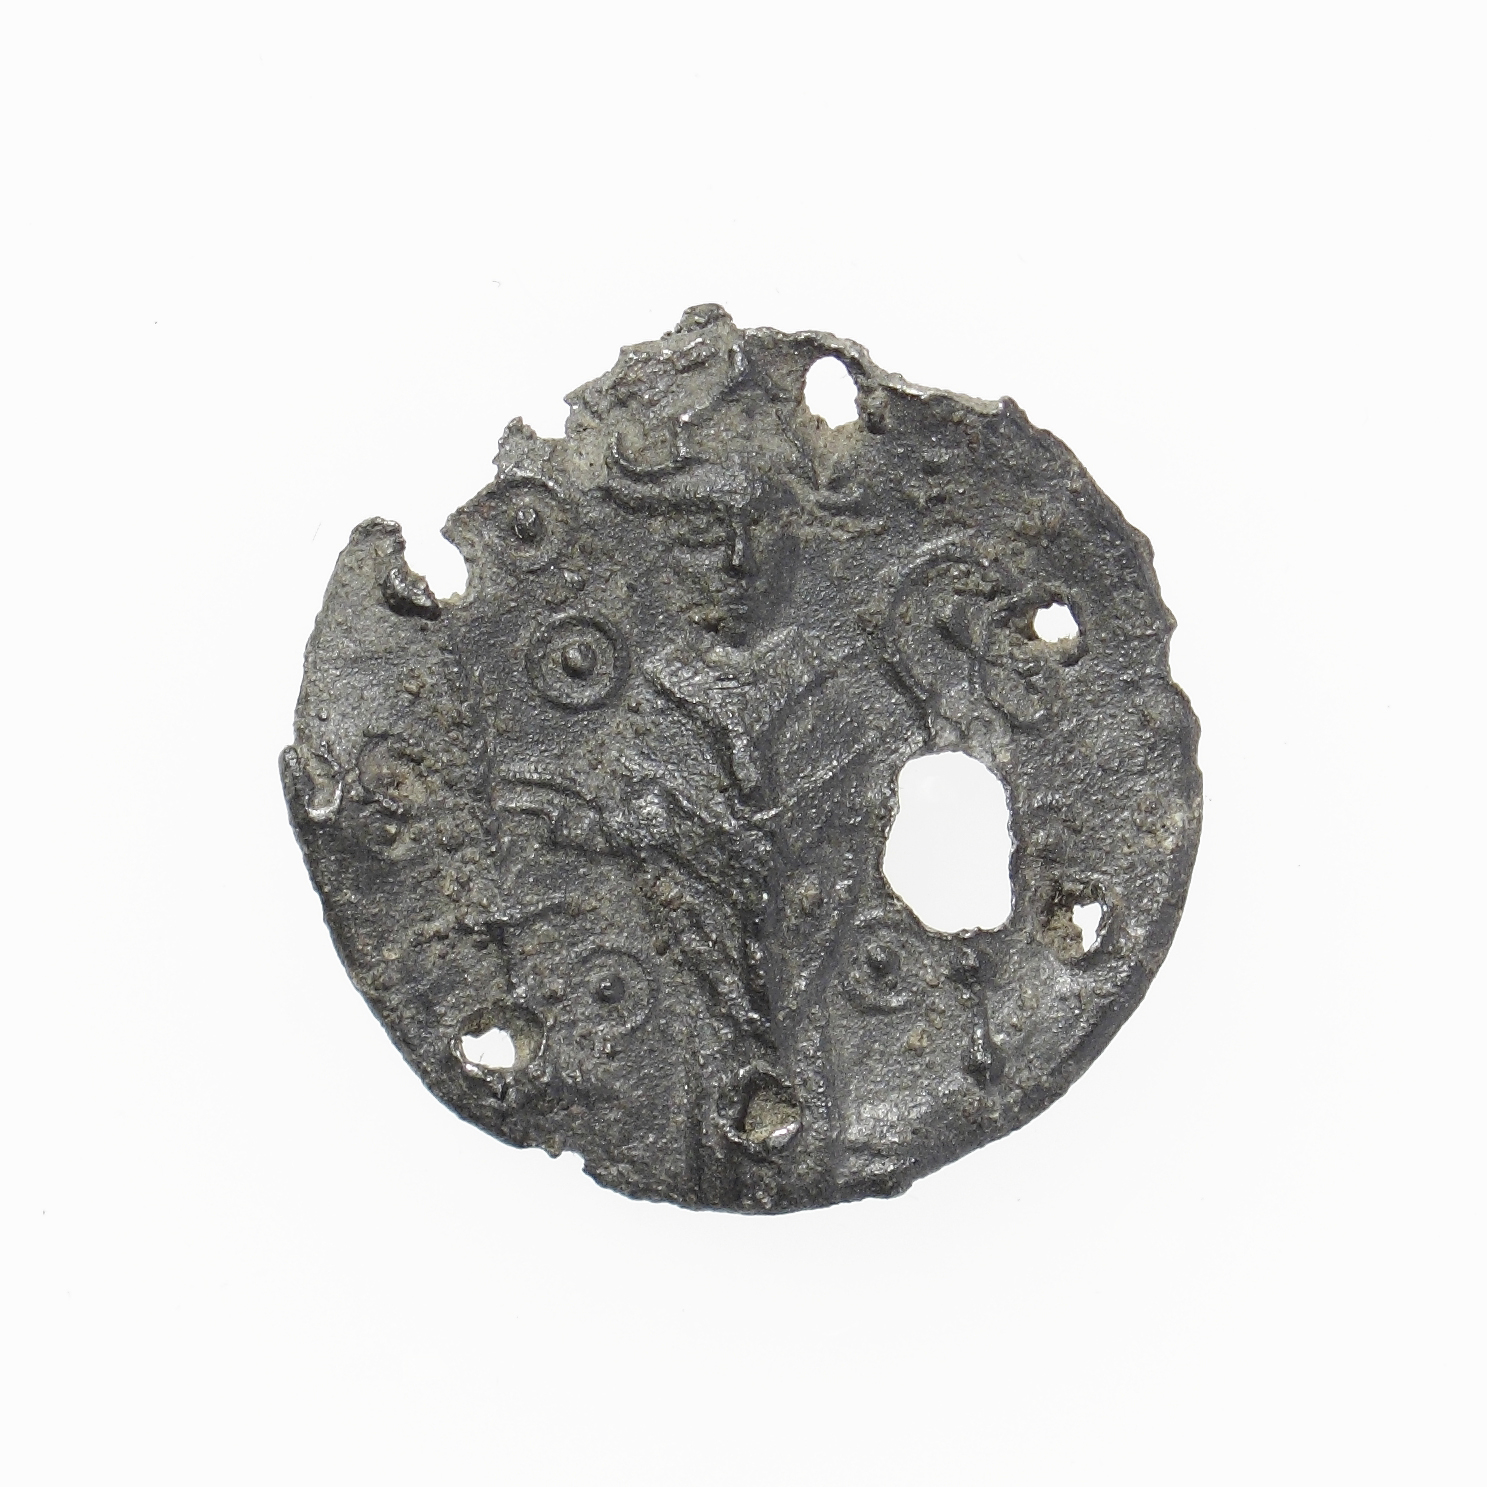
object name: pilgrim's badge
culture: french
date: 1301-1600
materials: lead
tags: saints